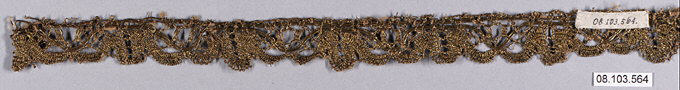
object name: piece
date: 1701-1800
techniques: lace